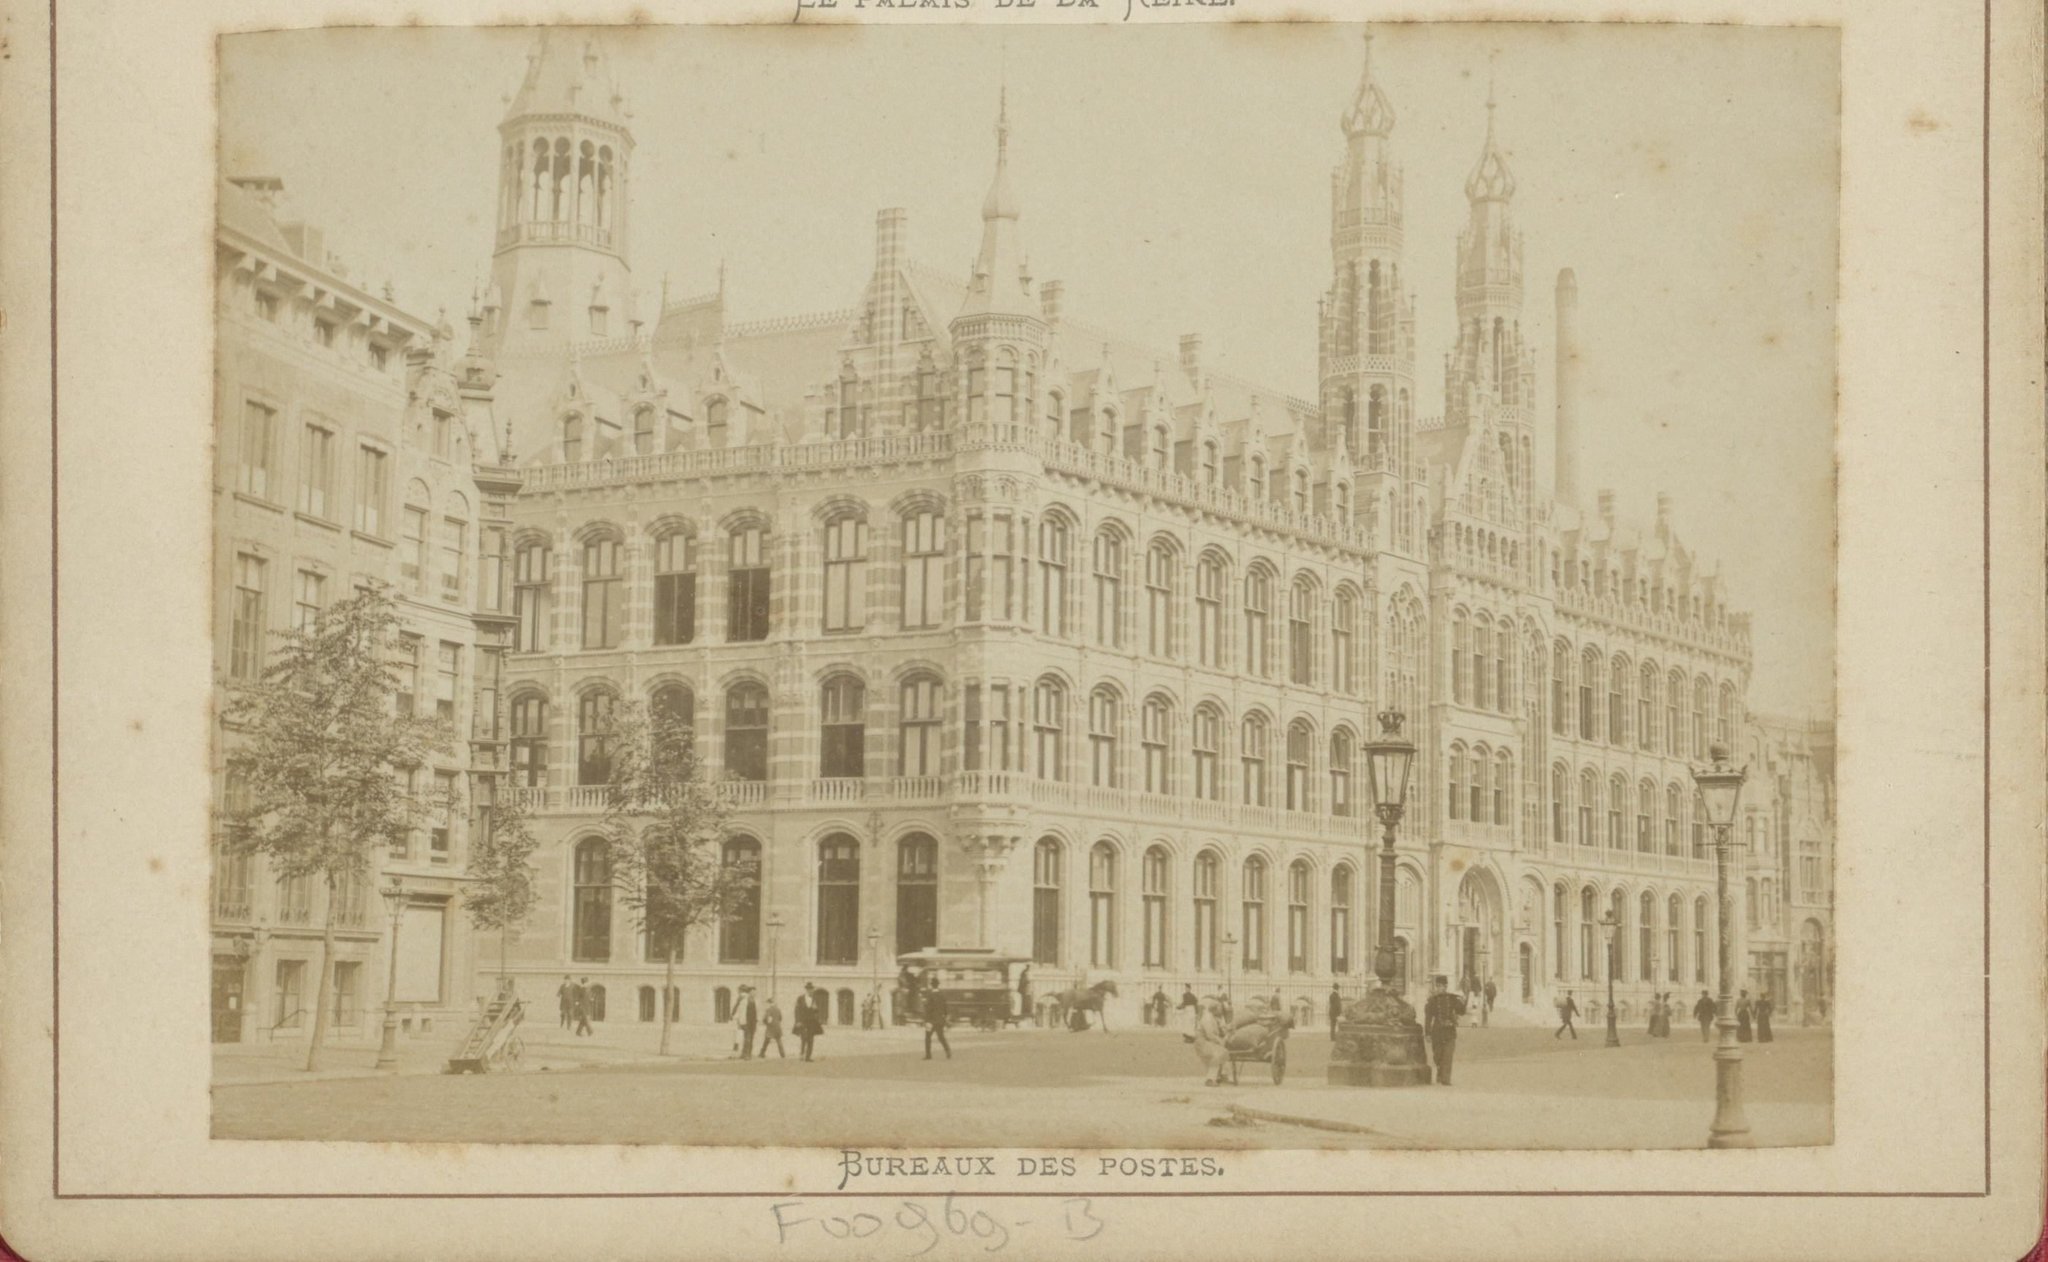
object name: photograph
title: Gezicht op het Amsterdamse Hoofdpostkantoor aan de Nieuwezijds Voorburgwal in Amsterdam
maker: andries jager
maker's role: publisher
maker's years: 1825-1905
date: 1899-1910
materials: cardboard, paper, photographic support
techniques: albumen print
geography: amsterdam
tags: diligence, omnibus, horse-tram, post-office, street (+ city(-scape) with figures, staffage)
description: Onderdeel van Leporelloalbum met 28 foto's van Amsterdam en omstreken.